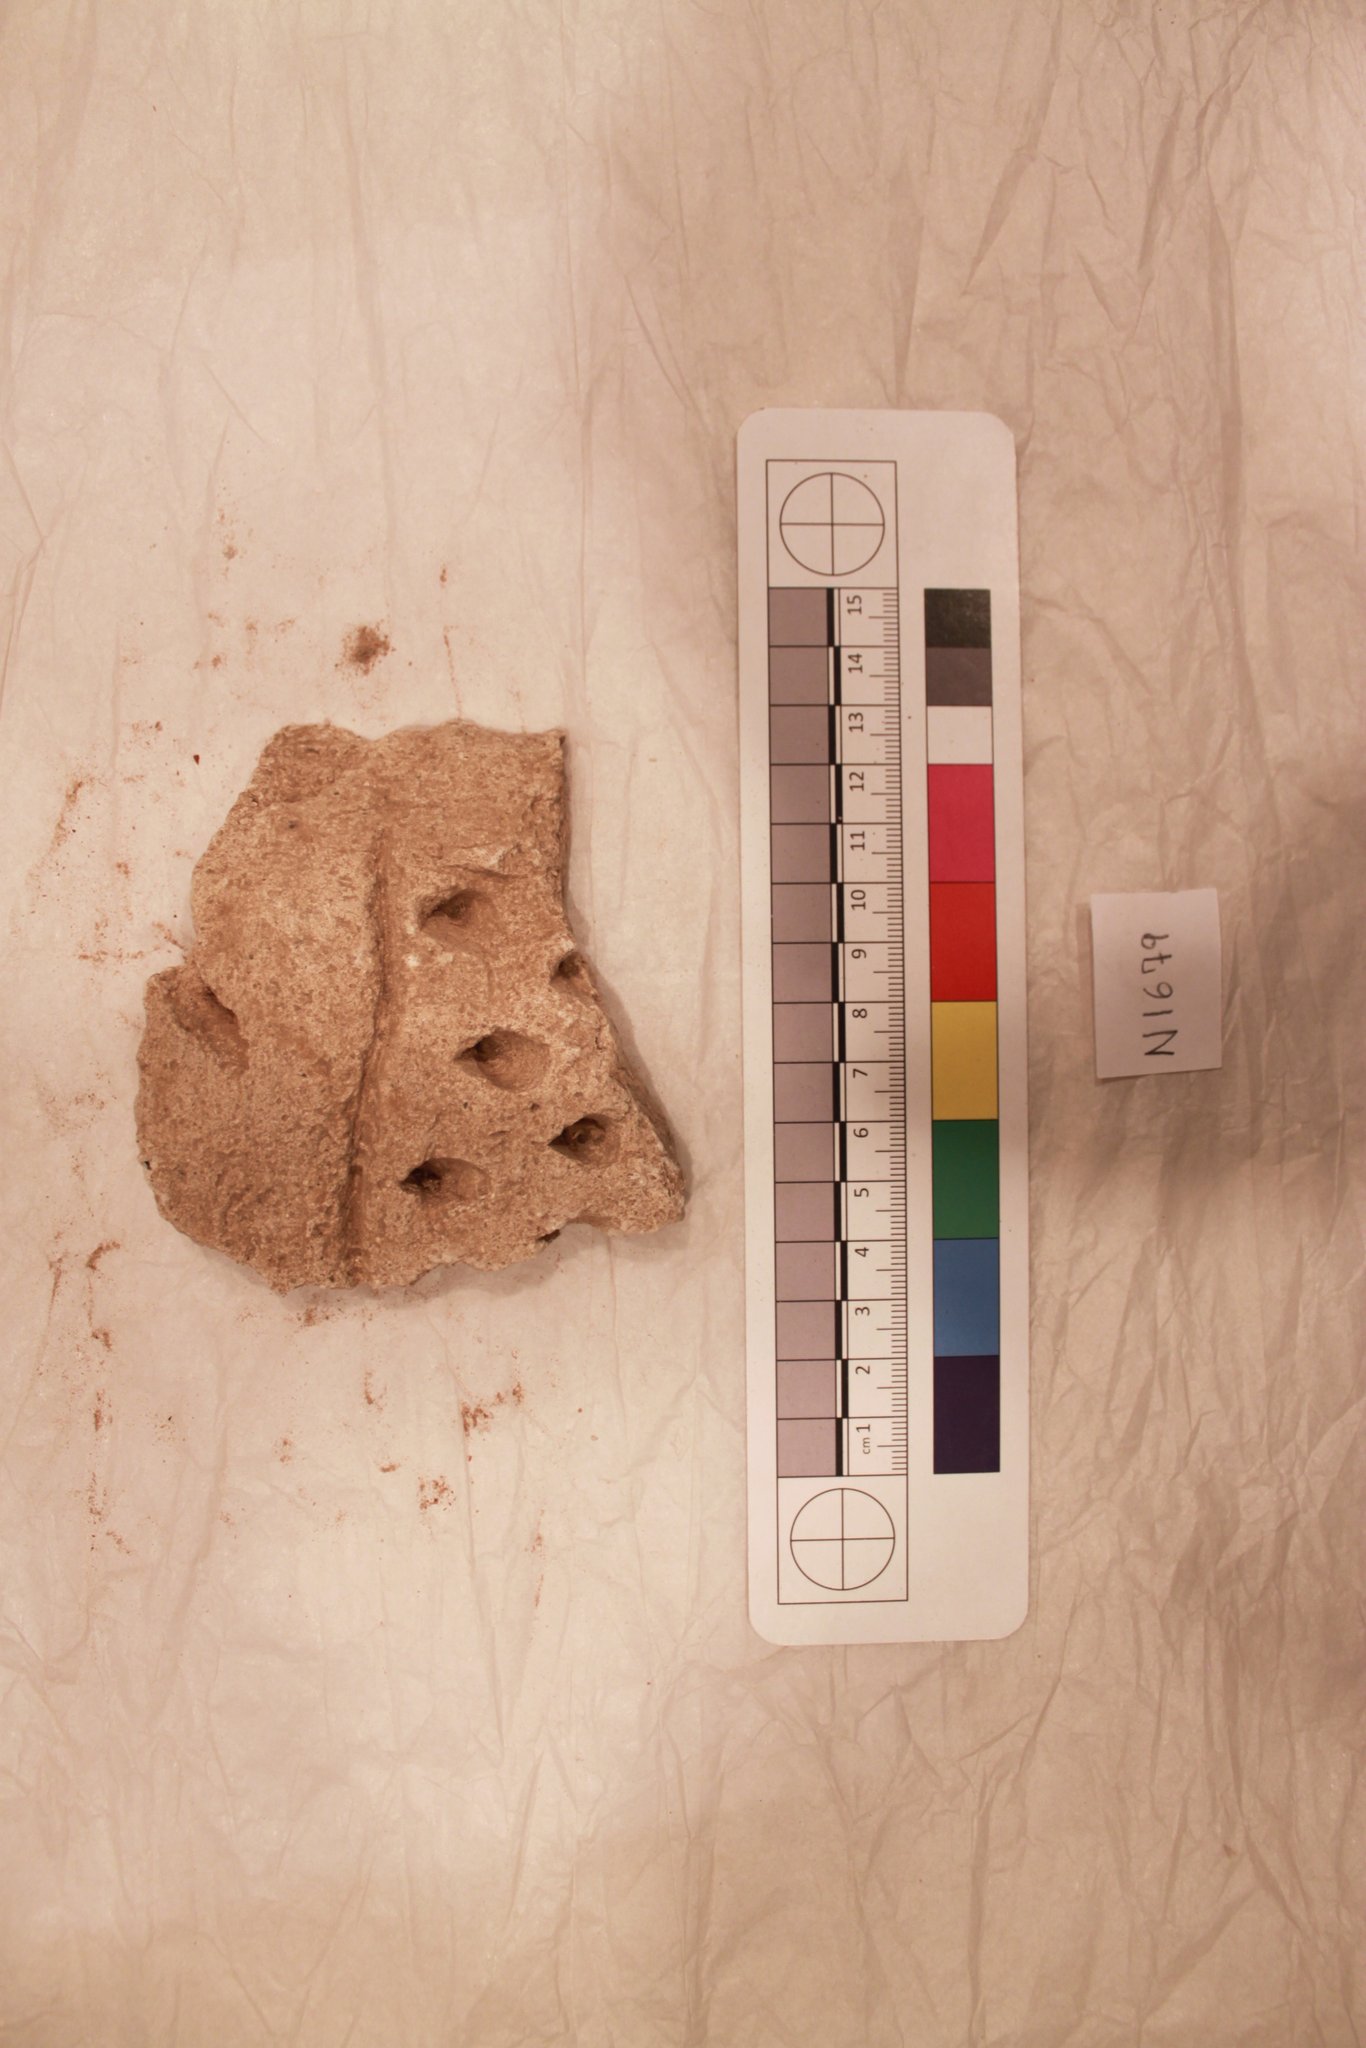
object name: fragment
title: Stucco Fragment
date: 701-1200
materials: plaster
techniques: carving, painting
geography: iran